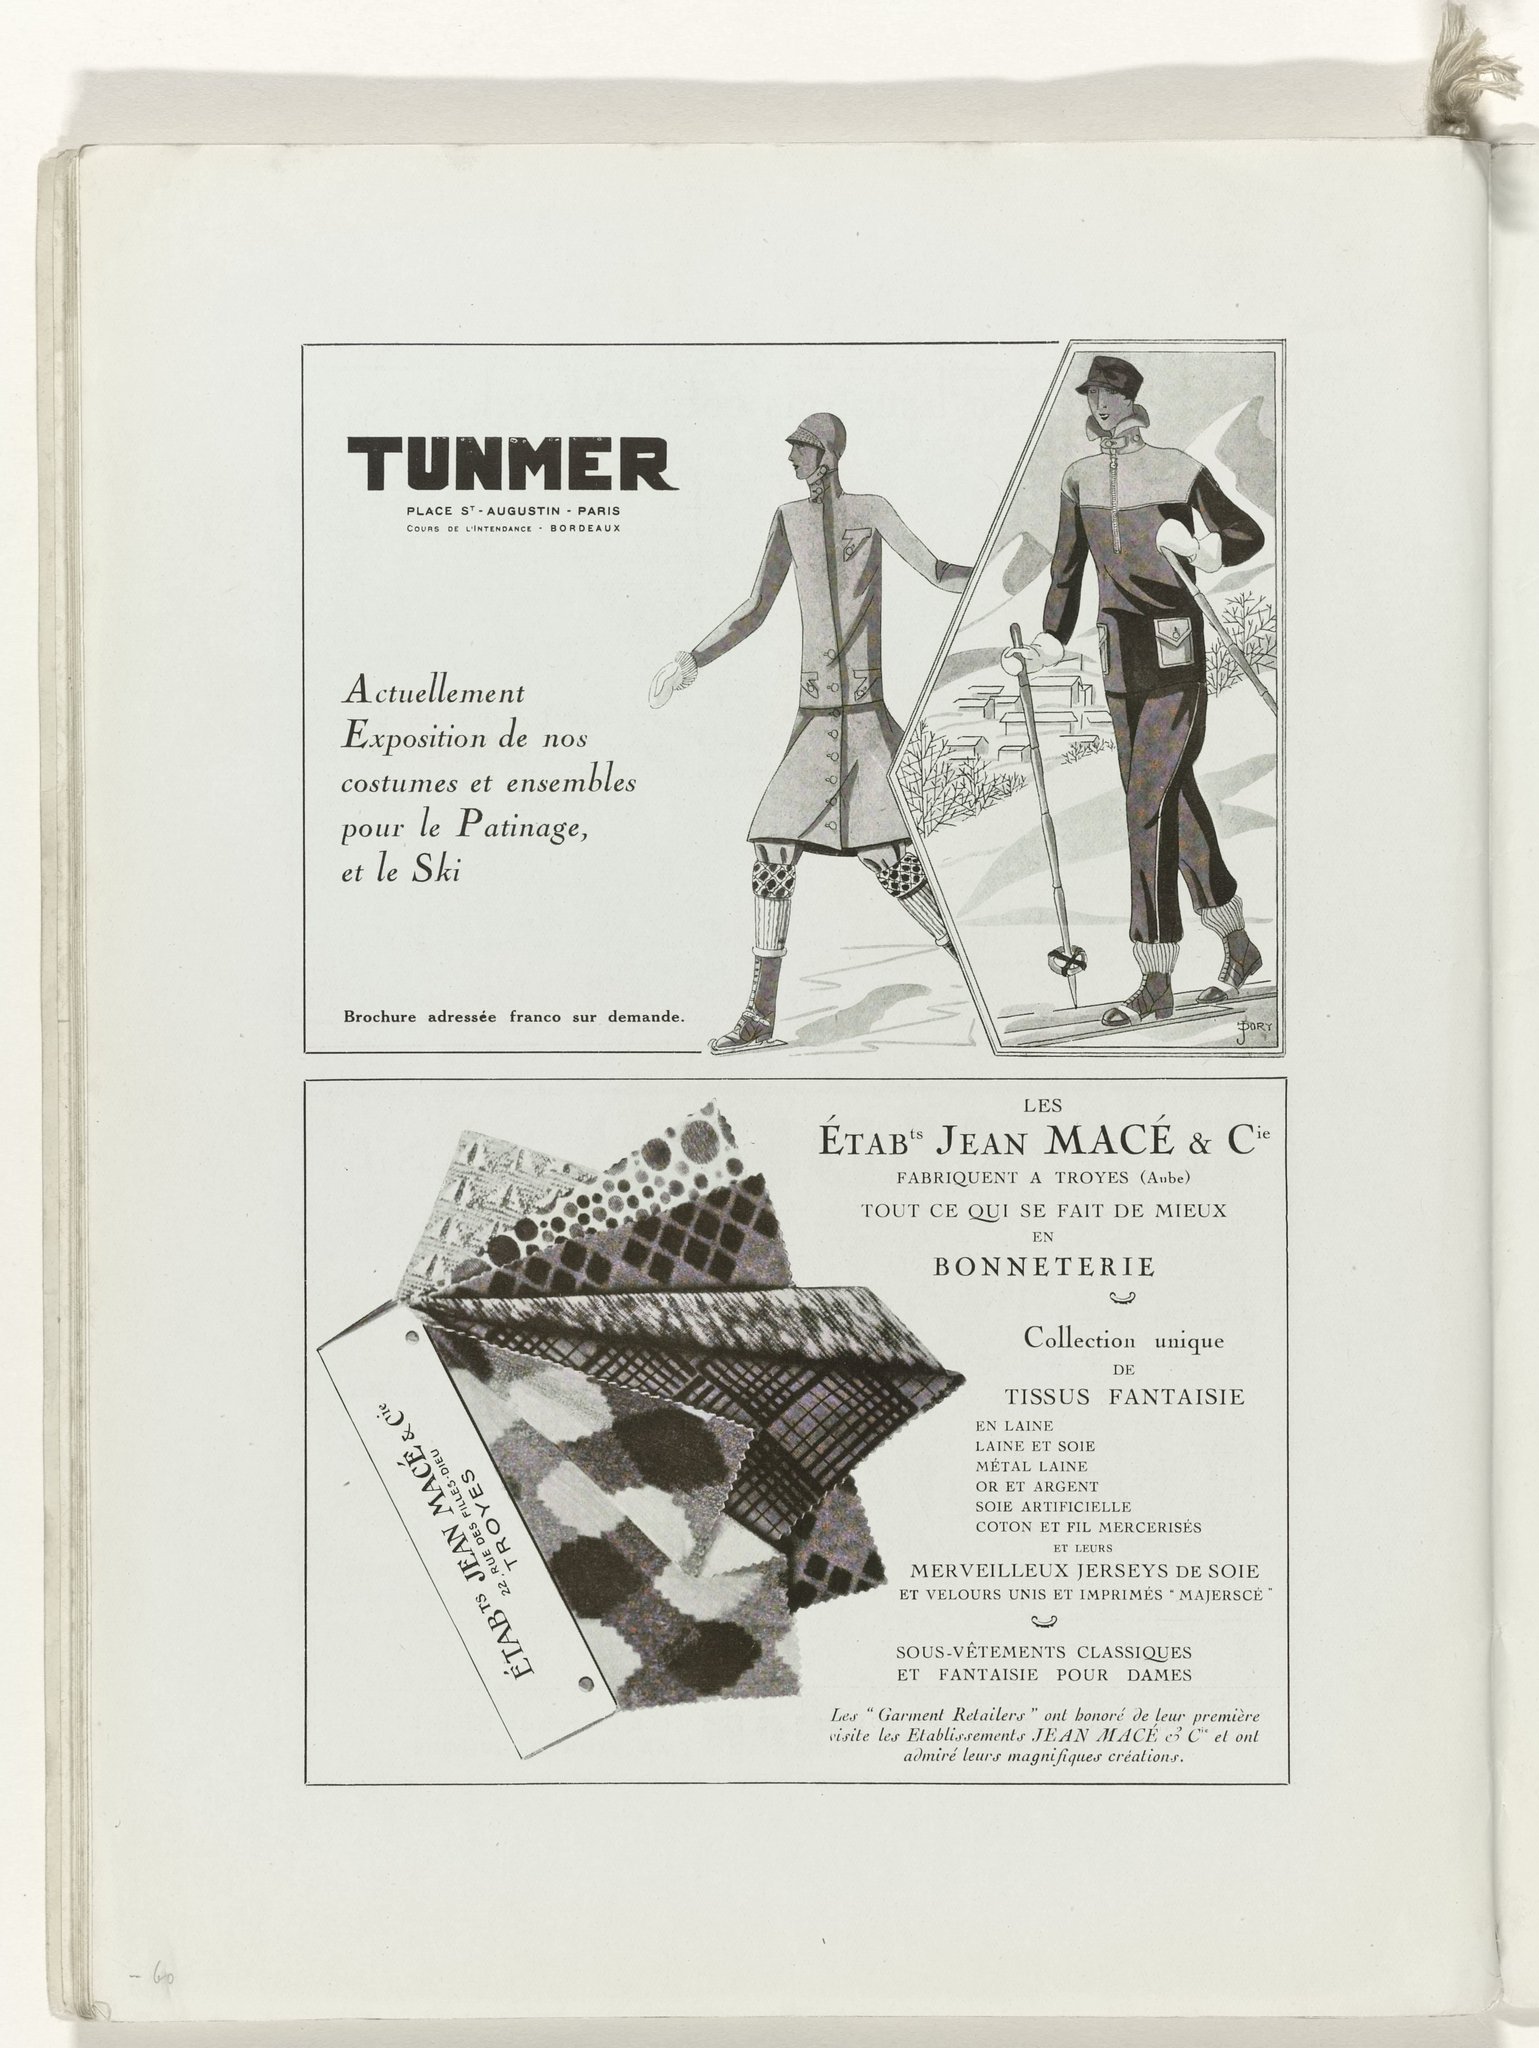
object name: fashion print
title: Art - Goût - Beauté, Feuillets de l' élégance féminine, Noël 1928, No. 100, 9e Année, p. 60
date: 1928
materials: paper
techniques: photography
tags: skis (winter sports) (+ equipment, outfit (sports, games, etc.)), fashion plates, textile fabric, cloth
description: Twee advertenties voor skikleding van Runmer en stoffen van Jean Macé & Cie. Pagina uit het modetijdschrift Art-Goût-Beauté (1920-1933).